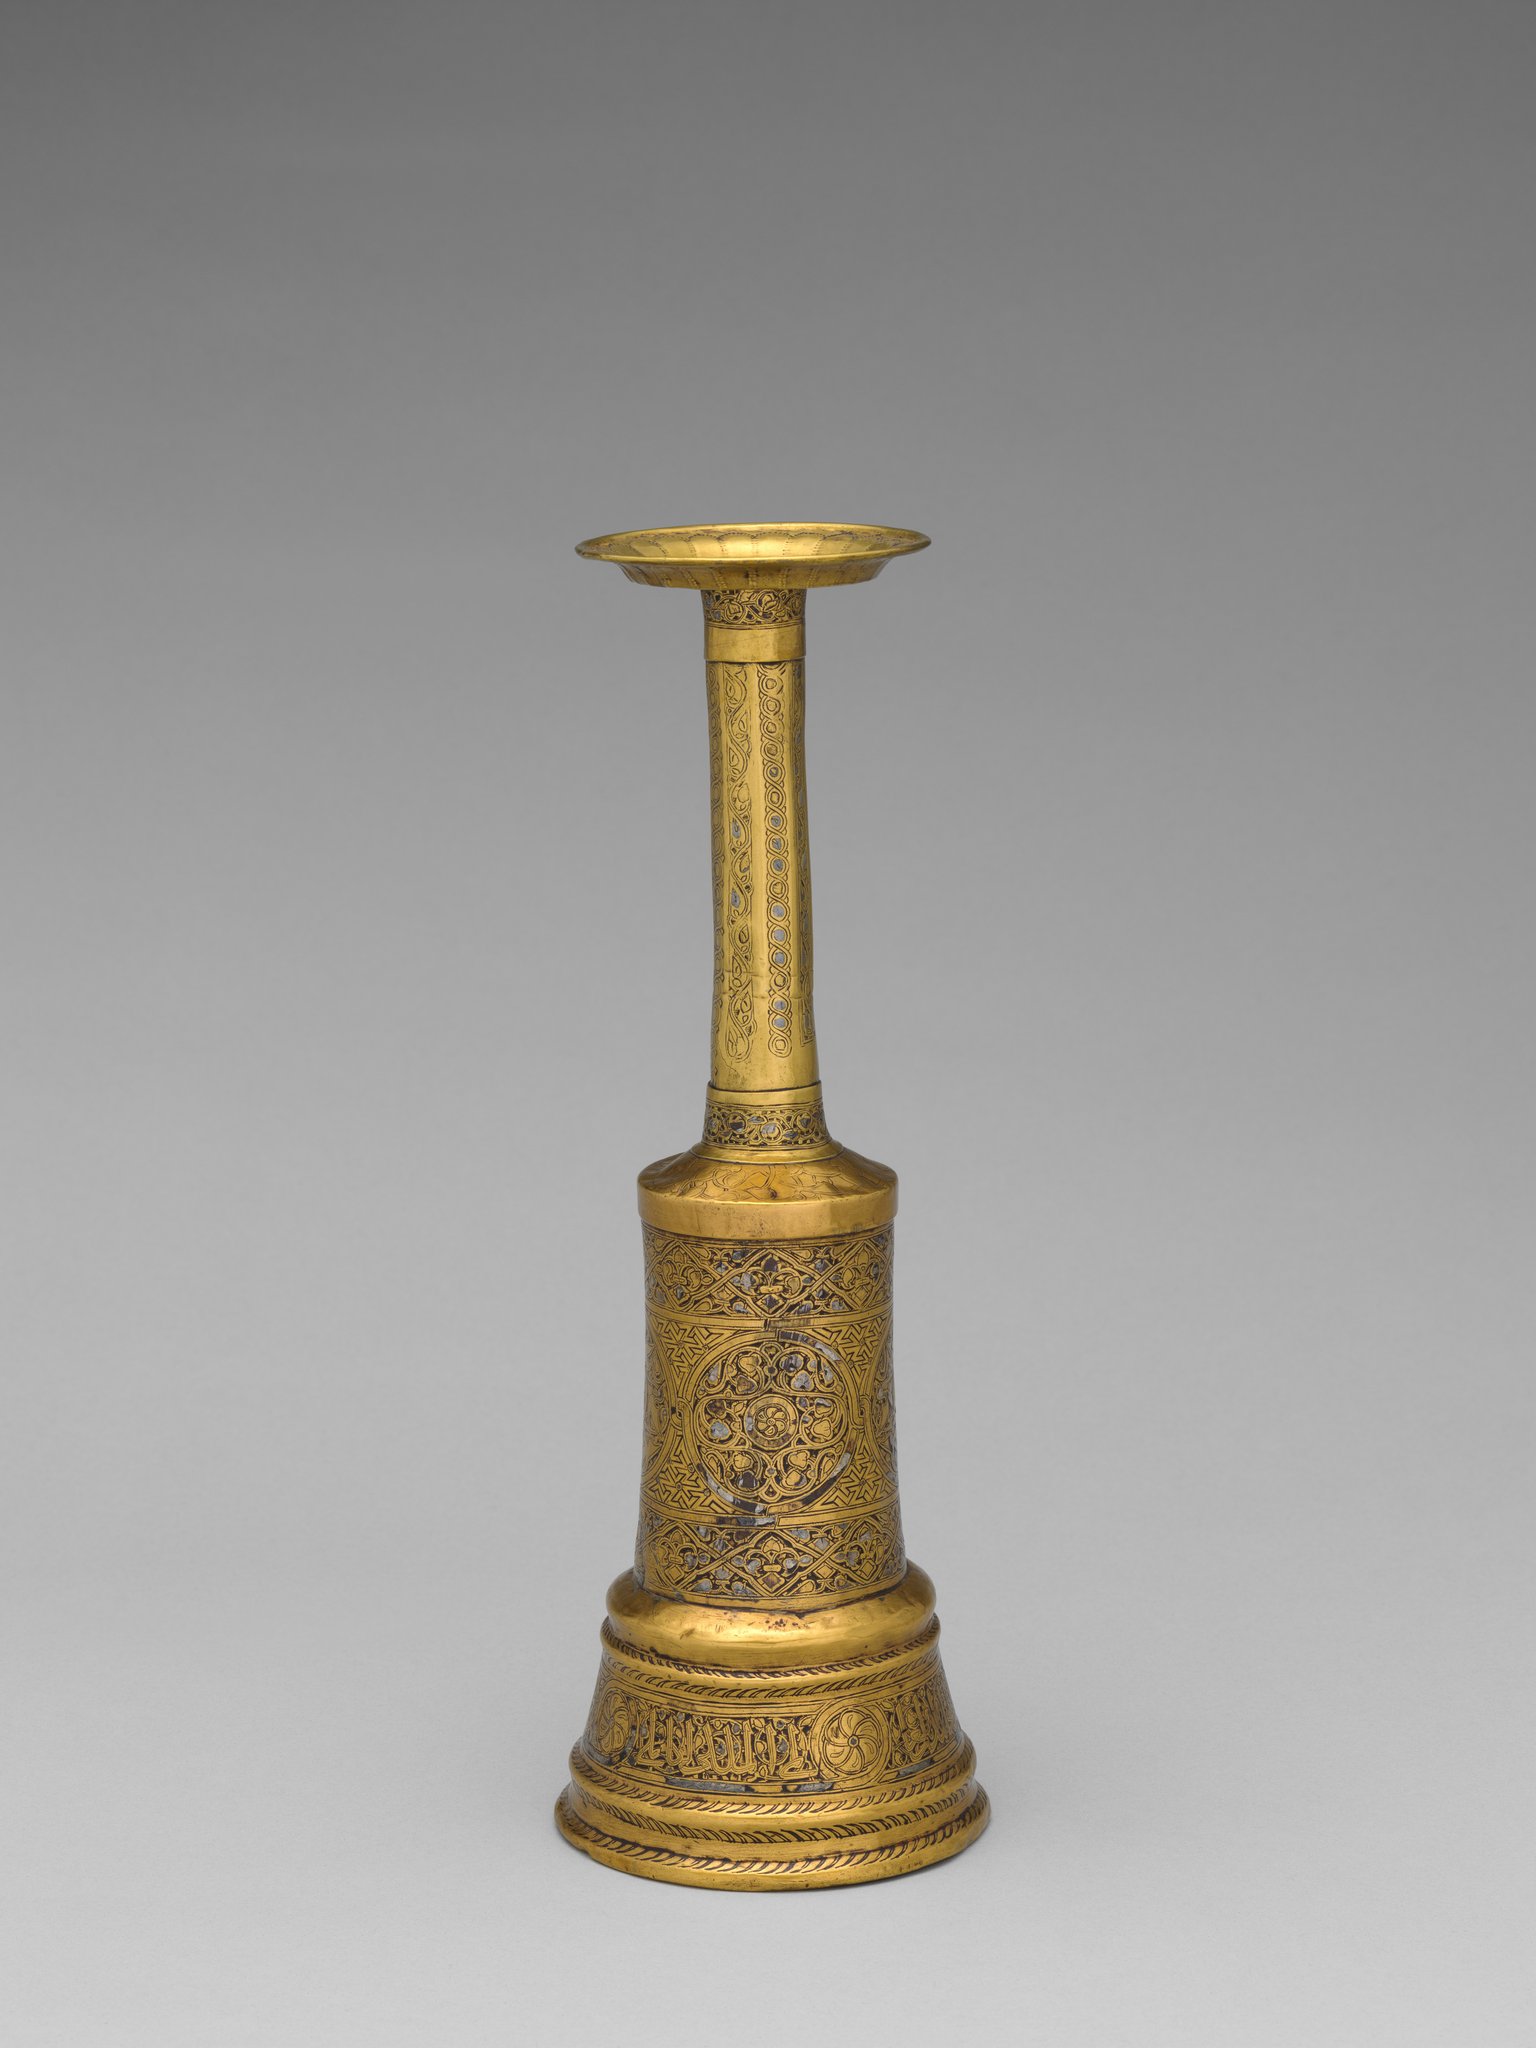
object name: candlestick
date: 1301-1350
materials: brass, silver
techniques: inlay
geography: egypt or syria